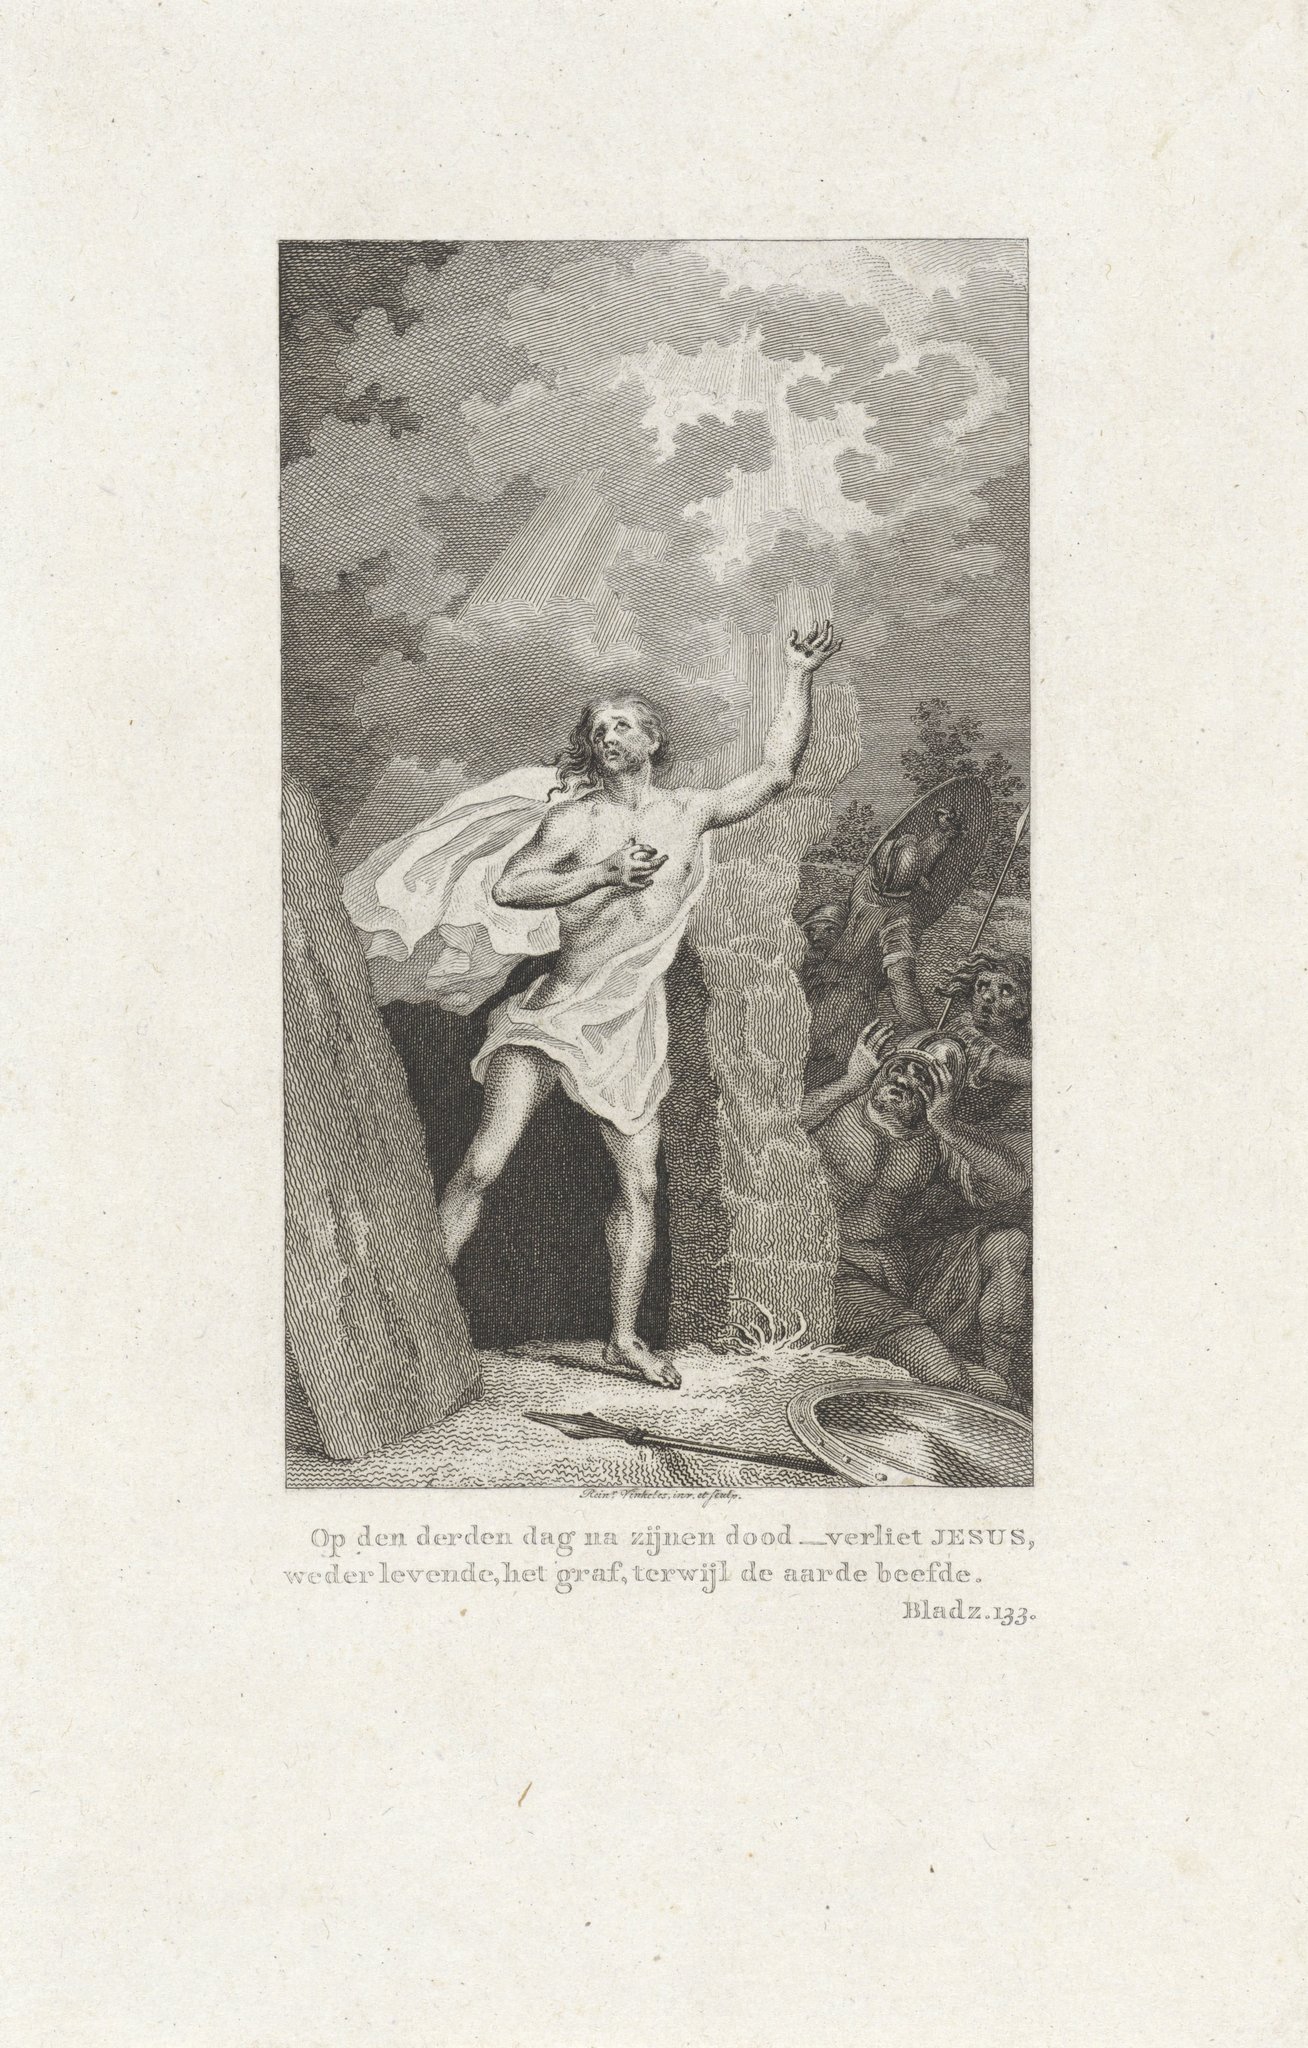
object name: print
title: Op den derden dag na zijnen dood - verliet Jesus, weder levende, het graf, terwijl de aarde beefde.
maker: reinier vinkeles (i)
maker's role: draughtsman, print maker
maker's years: 1741-1816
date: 1799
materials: paper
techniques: engraving, etching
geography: amsterdam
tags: resurrection of christ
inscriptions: collector's mark: Lugt 240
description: Illustratie in: Hamelsveld, Ysbrand van. Algemeene kerkelijke geschiedenis, der Christenen, deel 1. Haarlem: François Bohn, 1799, p. 133.